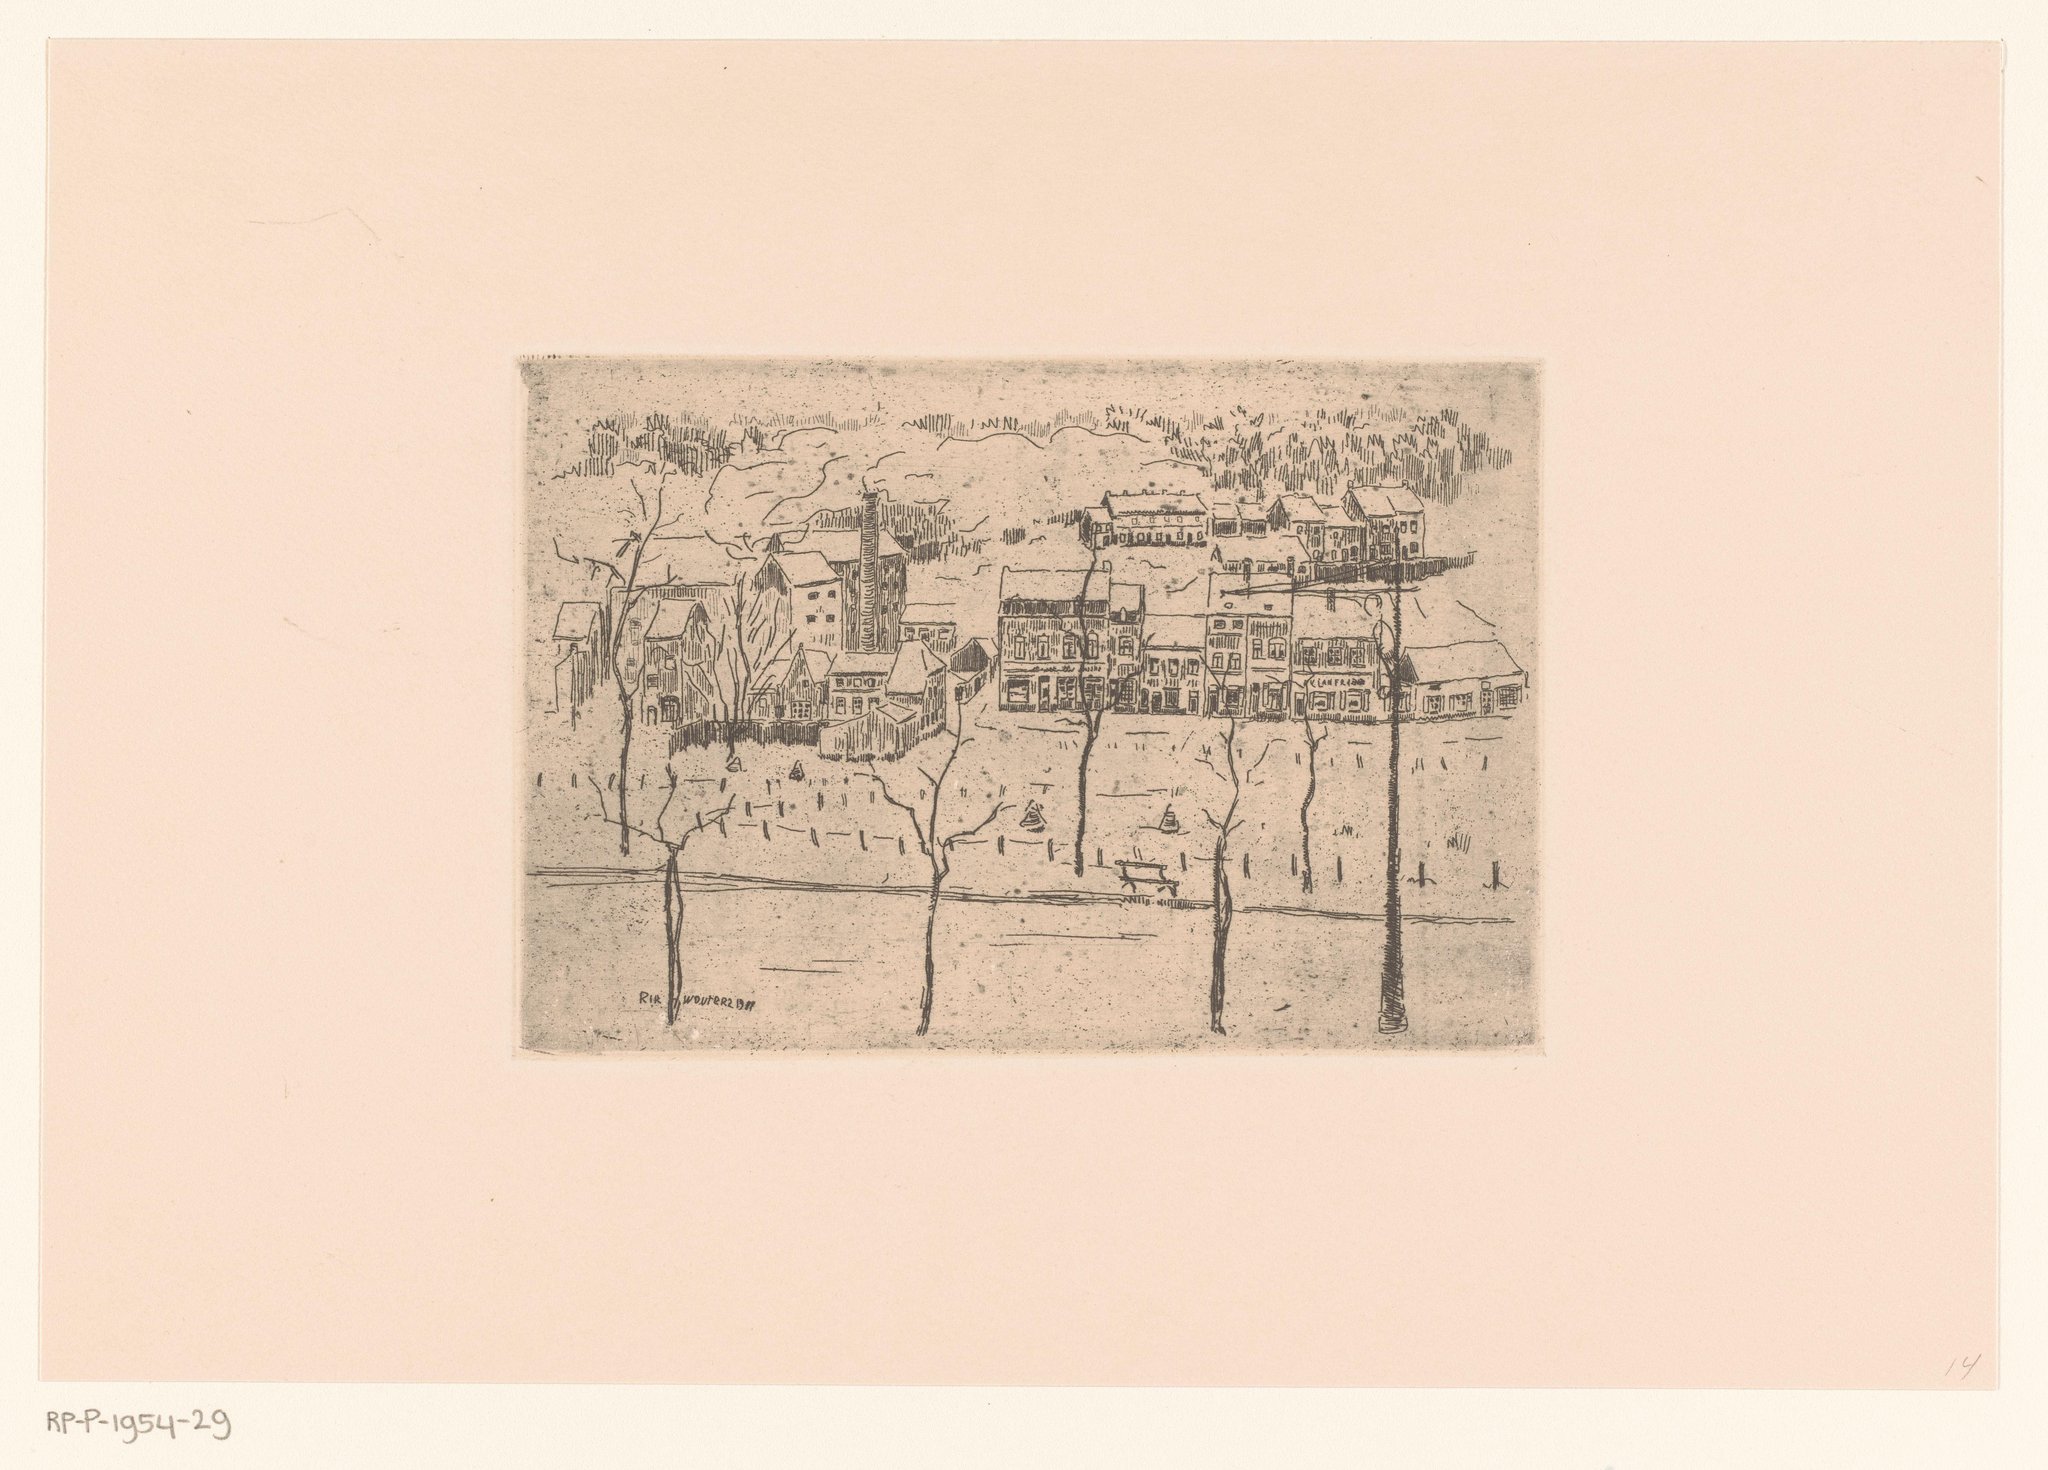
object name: print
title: Gezicht op Bosvoorde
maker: rik wouters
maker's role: draughtsman, print maker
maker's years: 1882-1916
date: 1911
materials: paper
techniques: drypoint, etching, intaglio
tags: city-view in general; 'veduta'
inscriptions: collector's mark: Lugt 2228